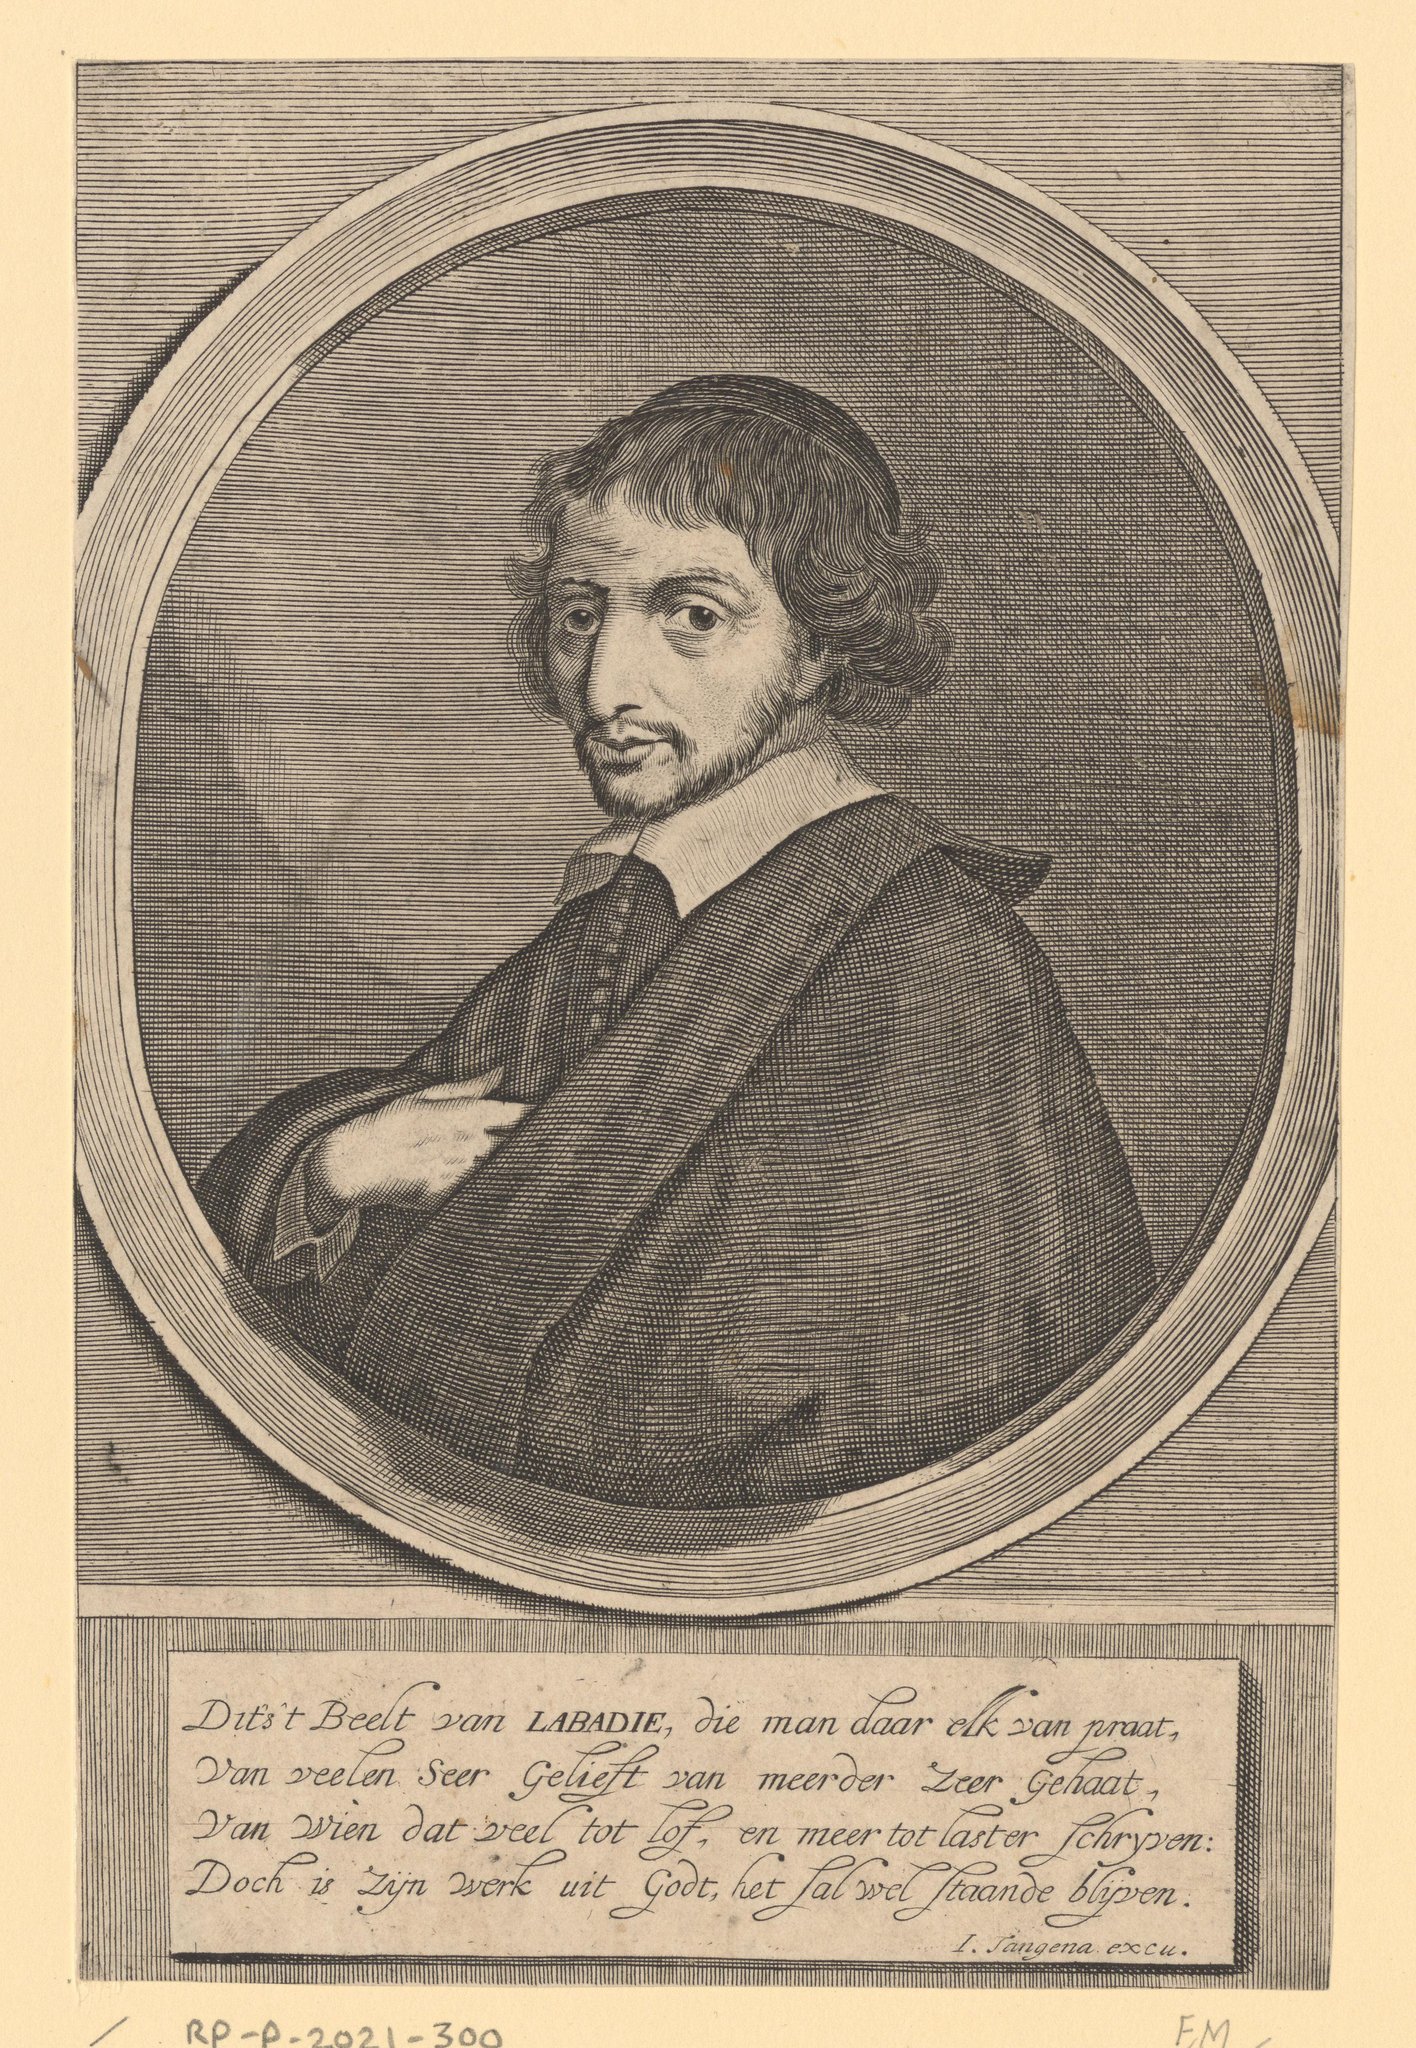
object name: print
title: Portret van Jean de Labadie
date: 1660-1692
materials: paper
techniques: engraving, etching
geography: leiden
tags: historical persons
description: Met vierregelig vers in het Nederlands onder het portret.